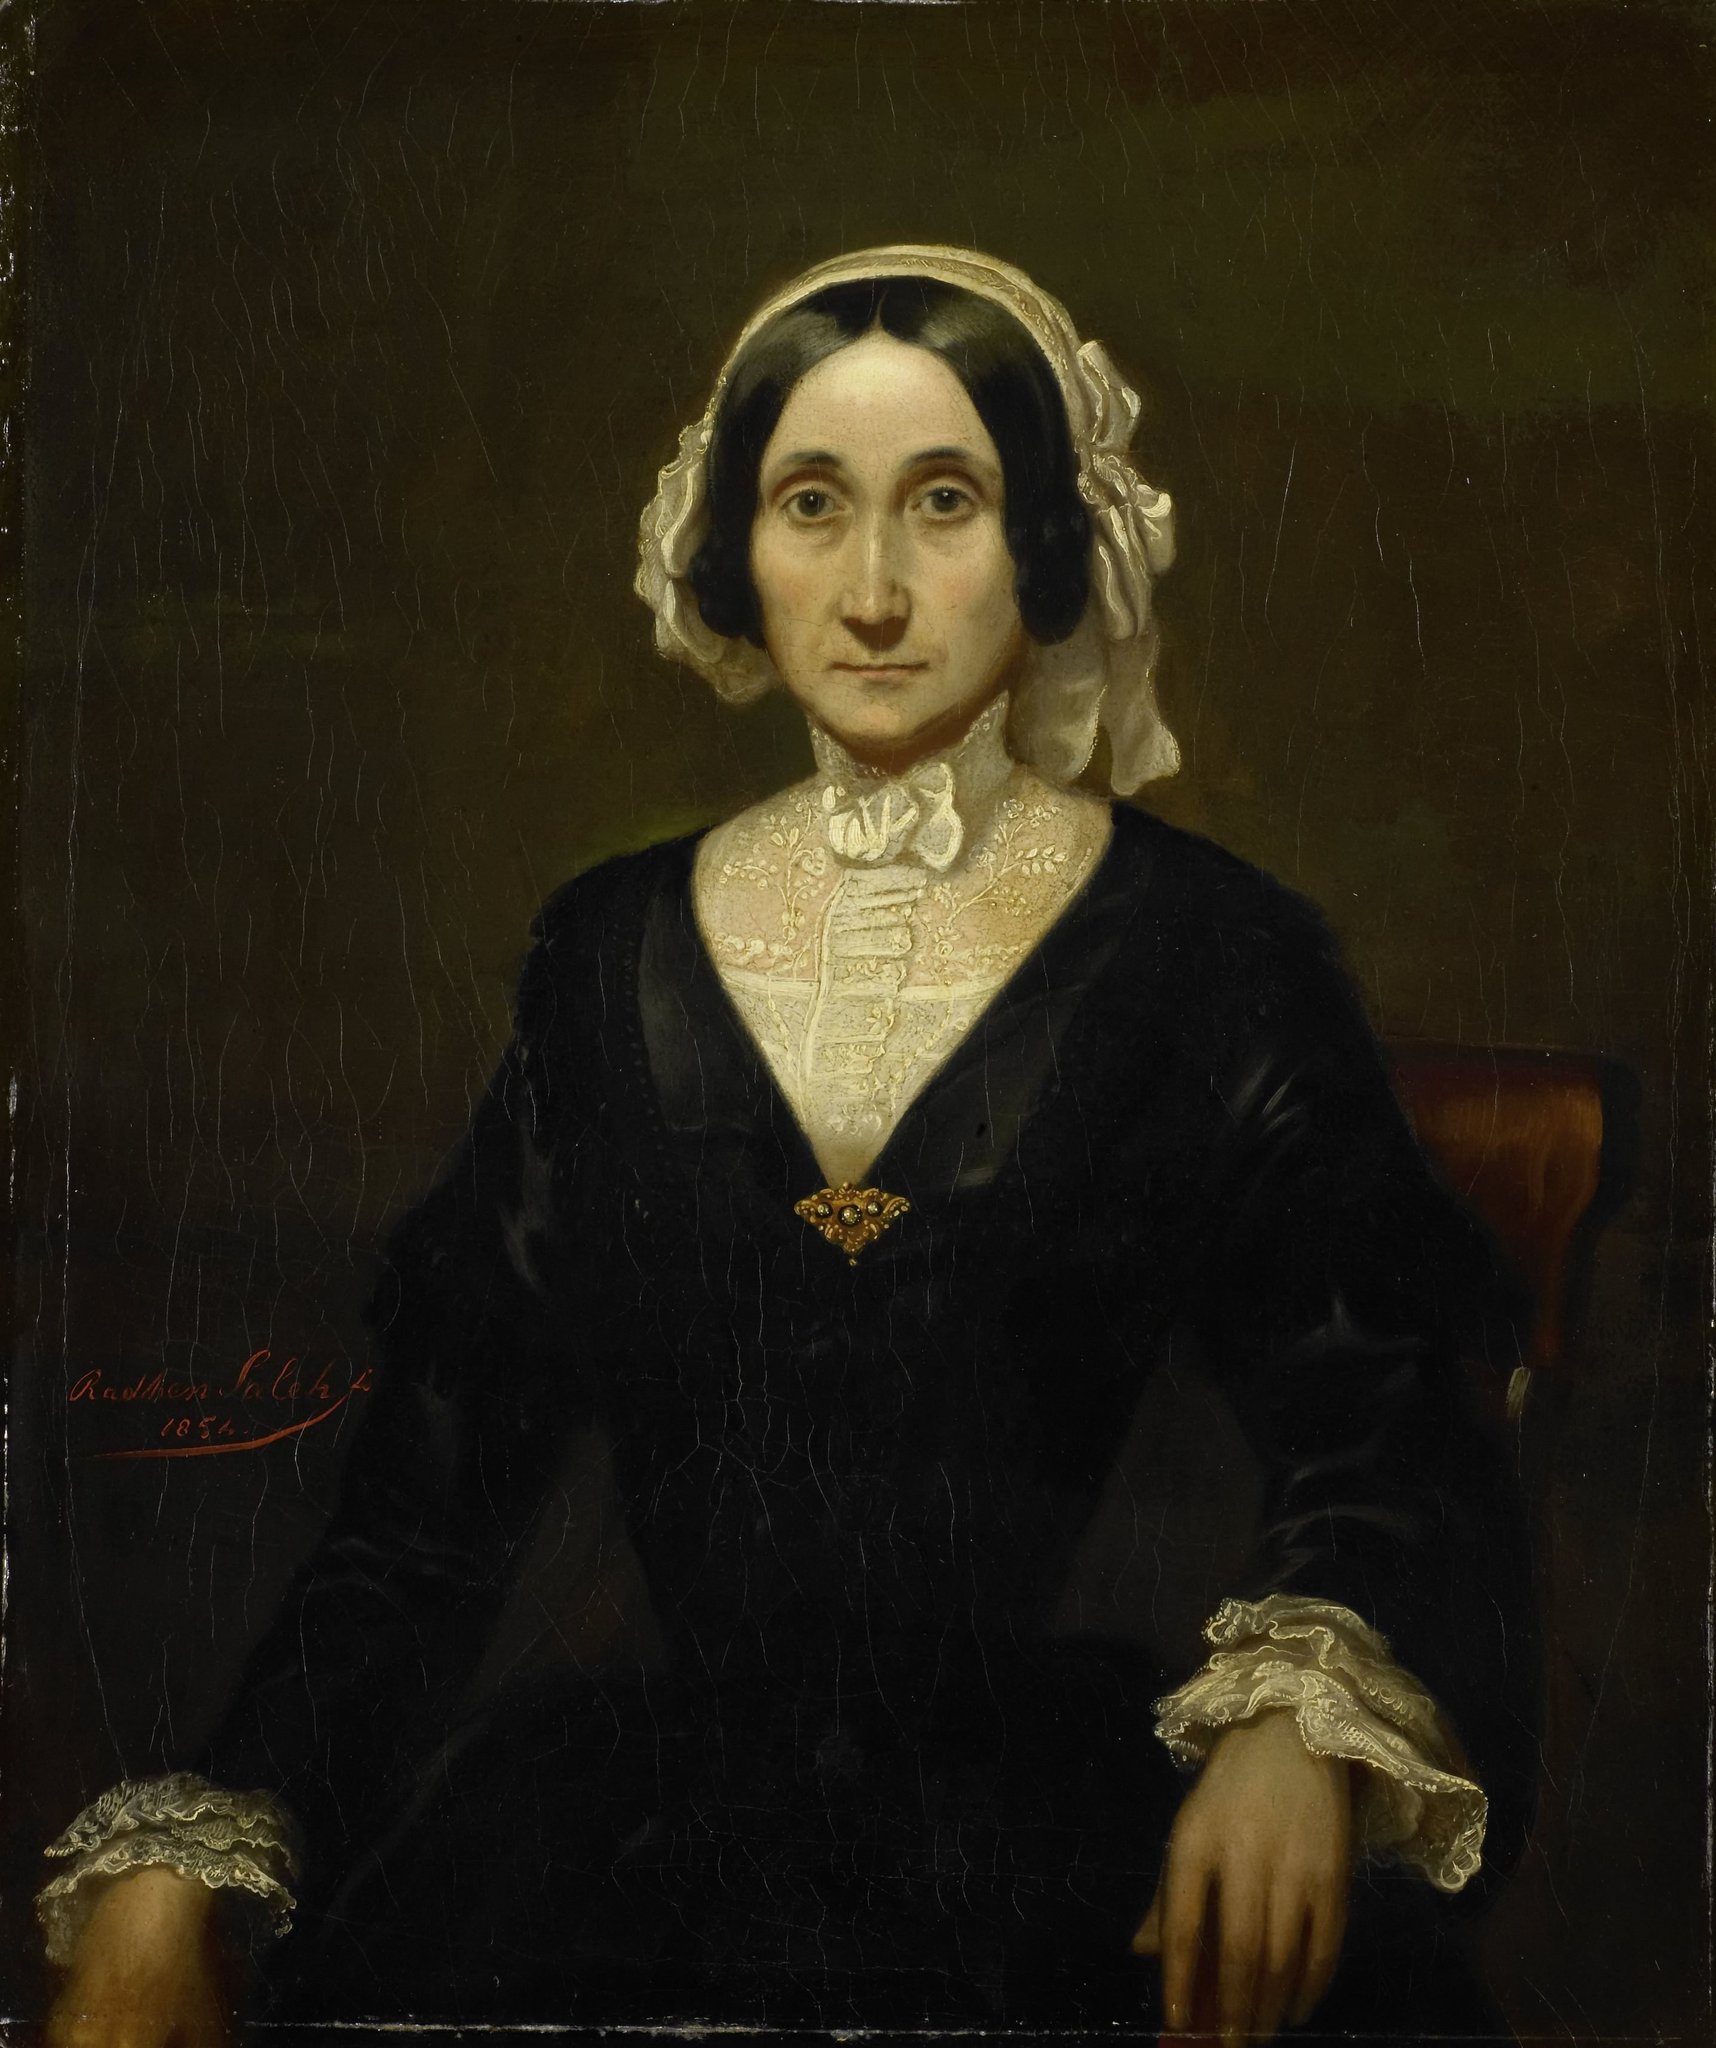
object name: painting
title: Portrait of Mrs. W.J.S. van Alphen, Baroness van Reede van Oudtshoorn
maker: raden sarief bastaman saleh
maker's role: draughtsman, painter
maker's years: 1814-1880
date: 1854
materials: canvas, oil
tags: arnhem, historical persons - bb - woman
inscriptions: signature and date: ‘Radhen Saleh f. 1854.’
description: Portret van mevrouw Wilhelmina Jeanne Sibille van Alphen (1827-78), barones van Reede van Oudtshoorn. Ten halven lijve, zittend in een stoel, en face. Op de achterzijde van het doek staan schetsen van een paard en een tijgerkop.